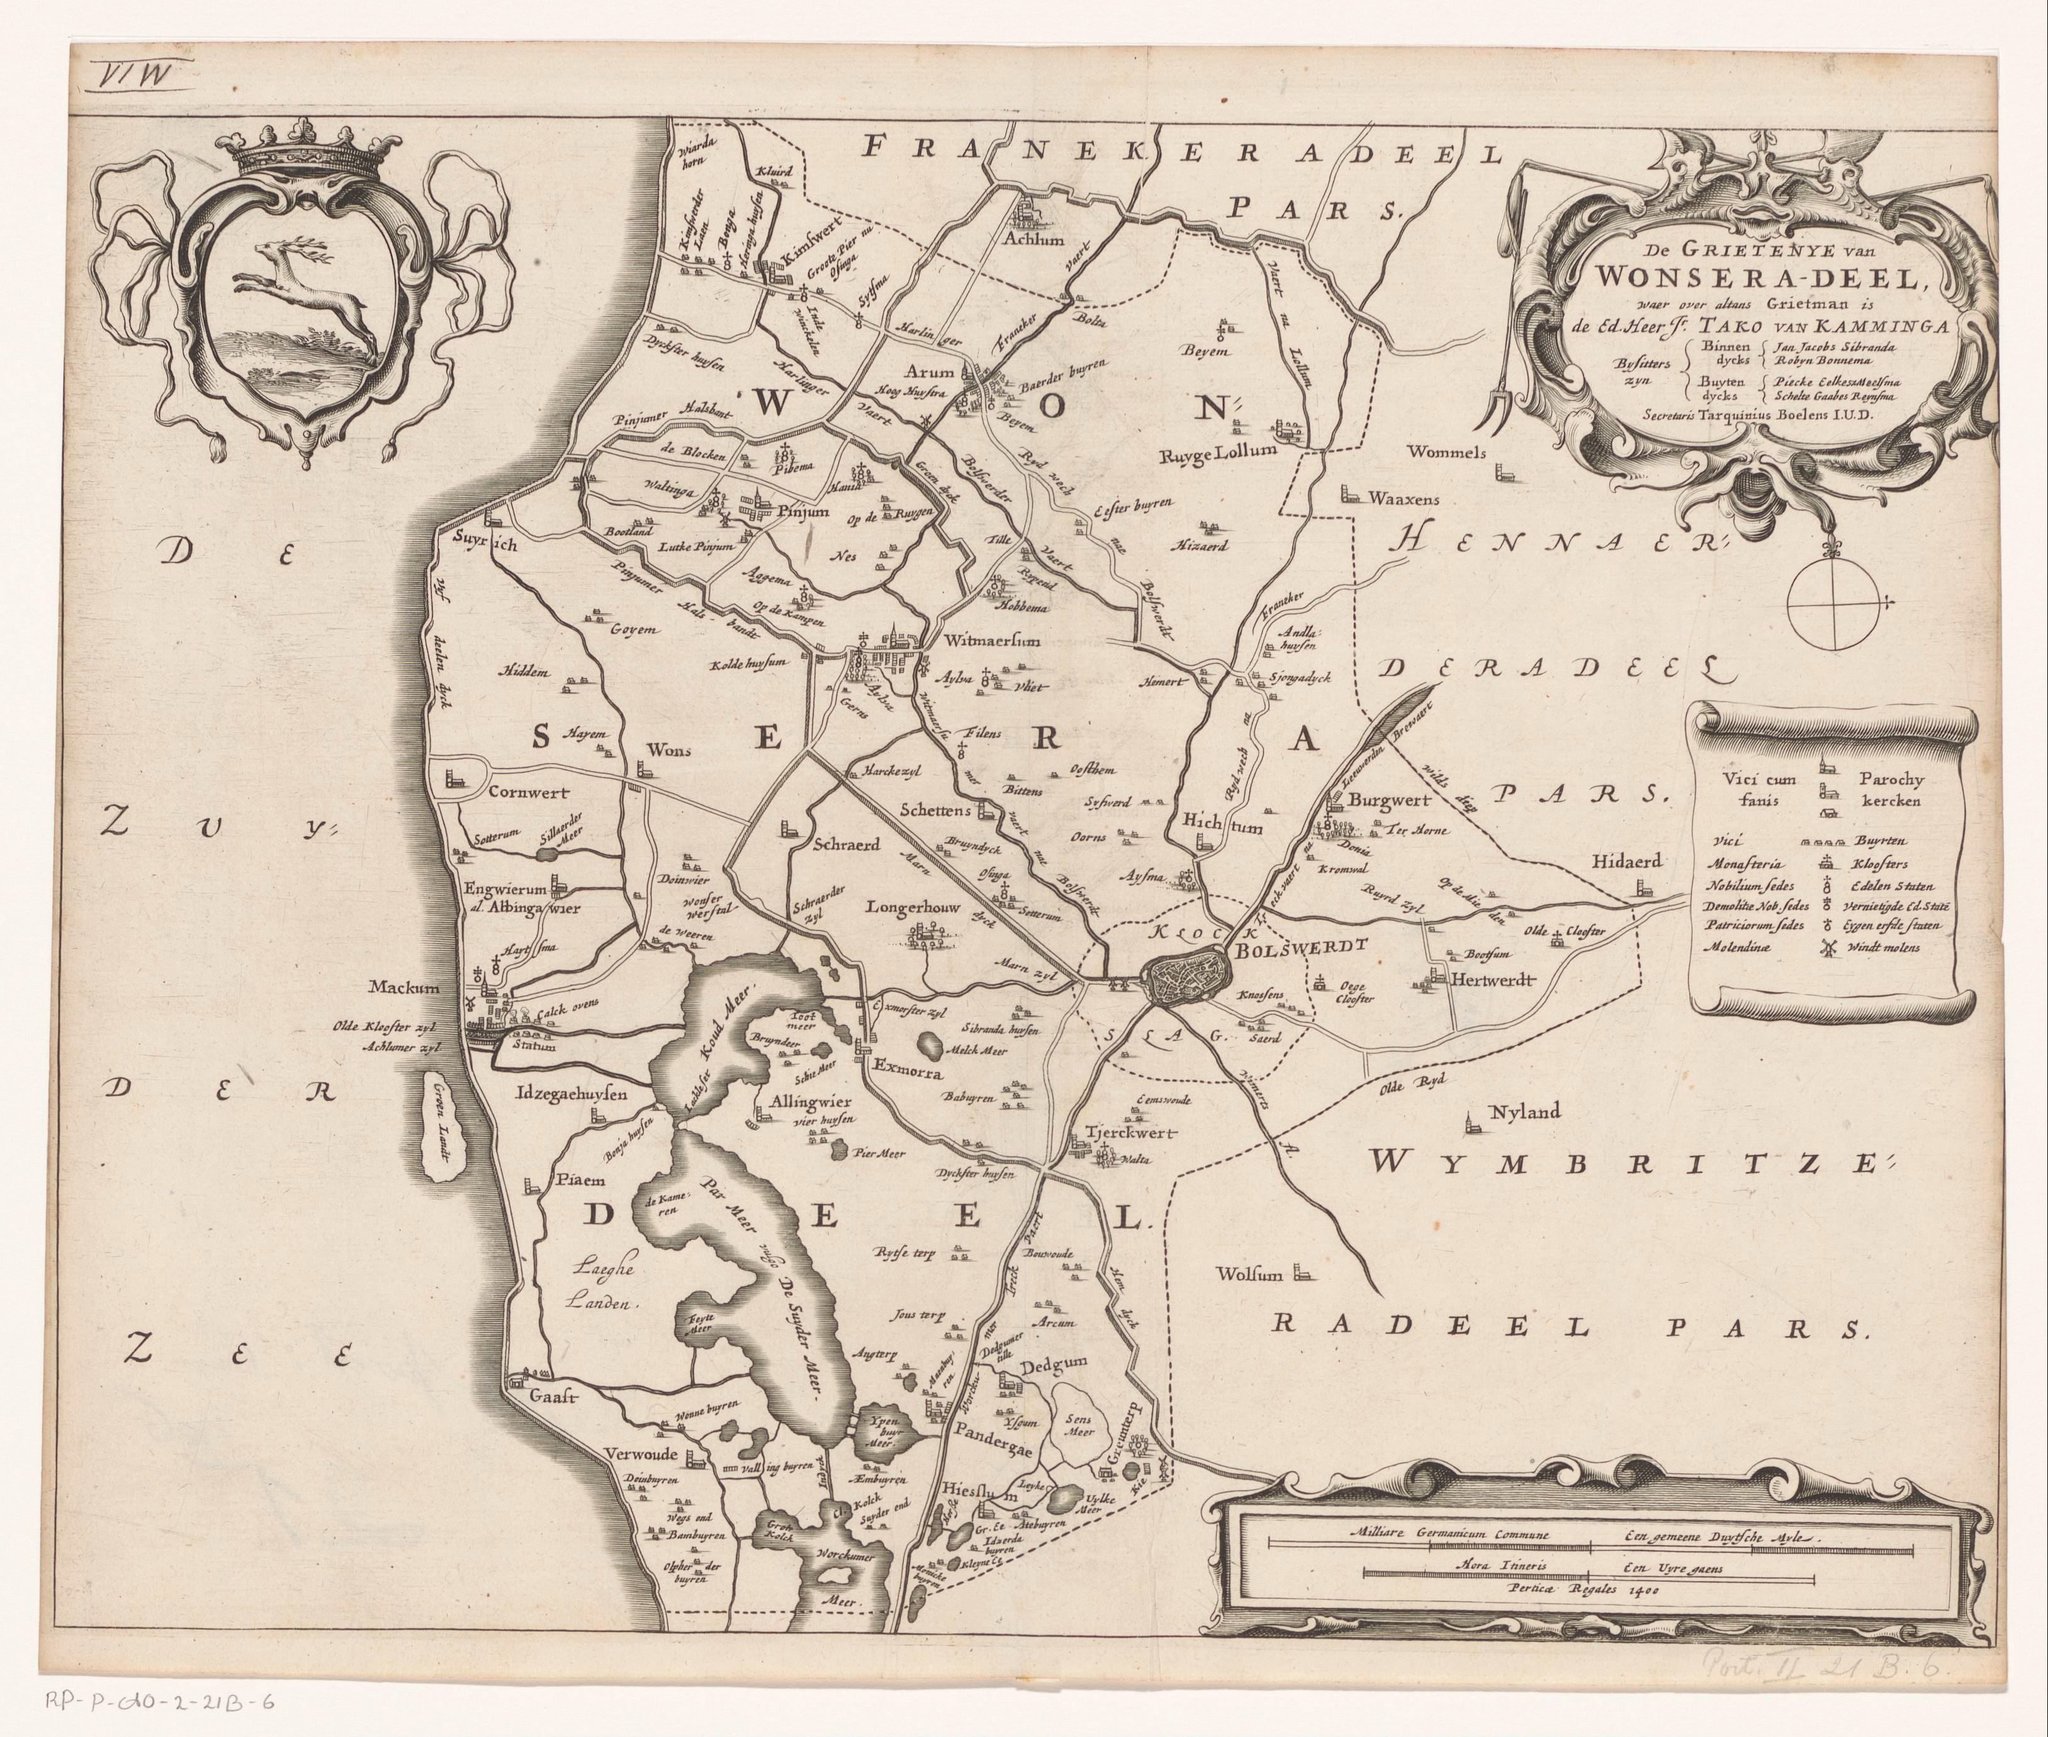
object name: print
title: Kaart van de grietenij Wonseradeel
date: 1664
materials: paper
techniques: engraving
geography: amsterdam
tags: coat of arms (as symbol of the state, etc.), maps of separate countries or regions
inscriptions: collector's mark: Lugt 2228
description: Linksboven het wapen van Wonseradeel. Rechtsboven cartouche met titel en bestuurlijke informatie over de grietenij, daaronder legenda. Rechtsonder twee schaalstokken: Milliare Germanicum commune / Een gemeene Duytsche myle, Hora itineris - perticae regales 1400 / Een uyre gaens.